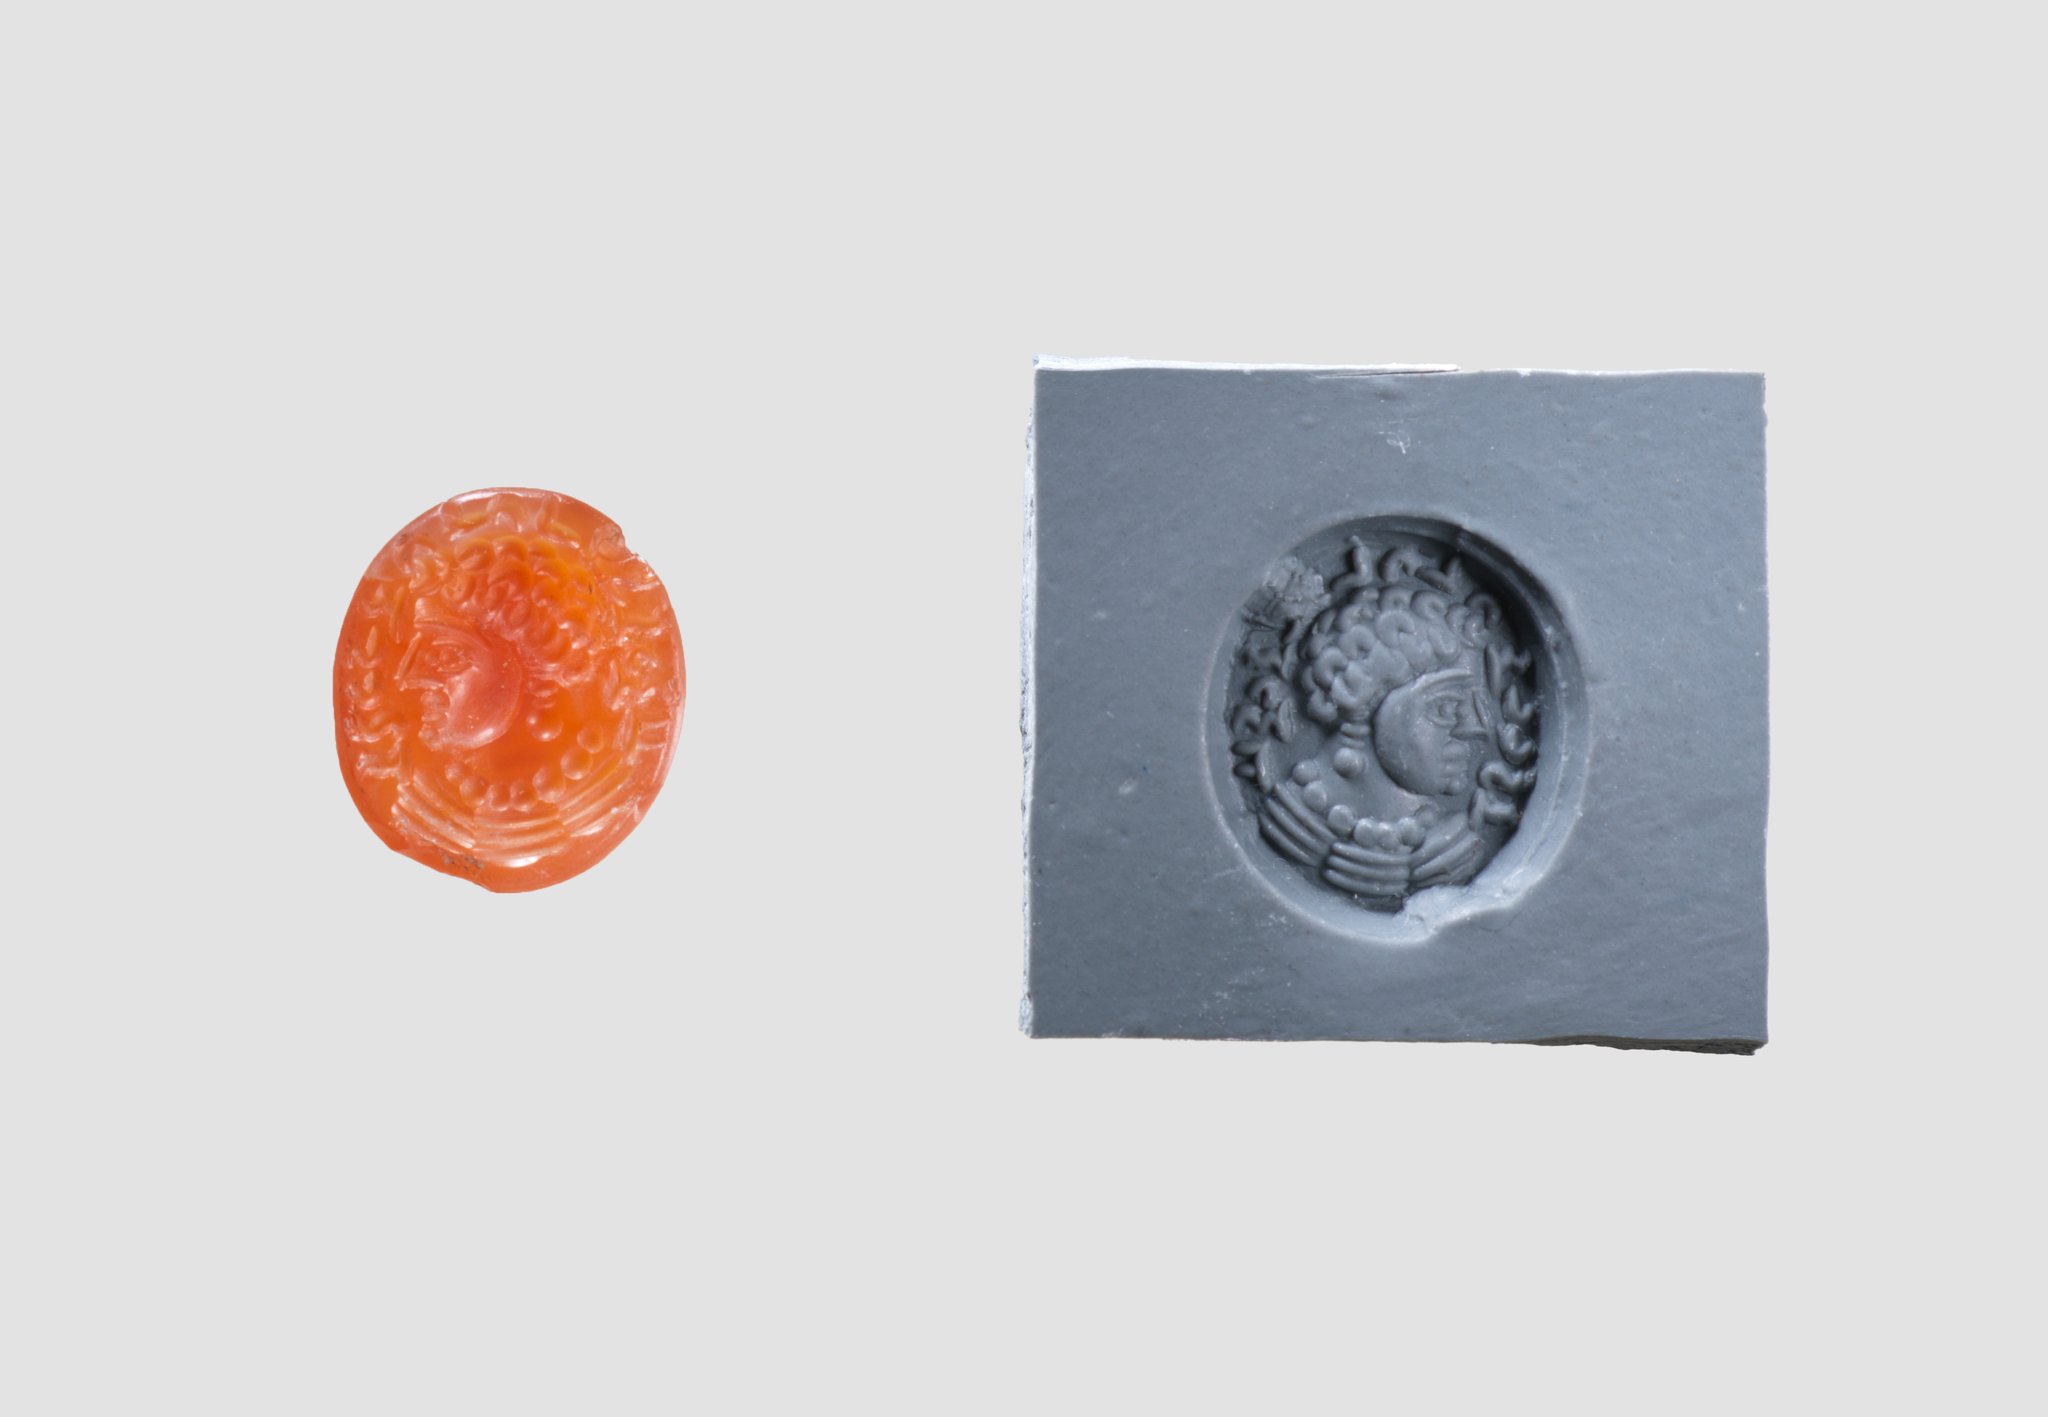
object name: stamp seal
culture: sasanian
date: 301-333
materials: gemstone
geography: iran or mesopotamia